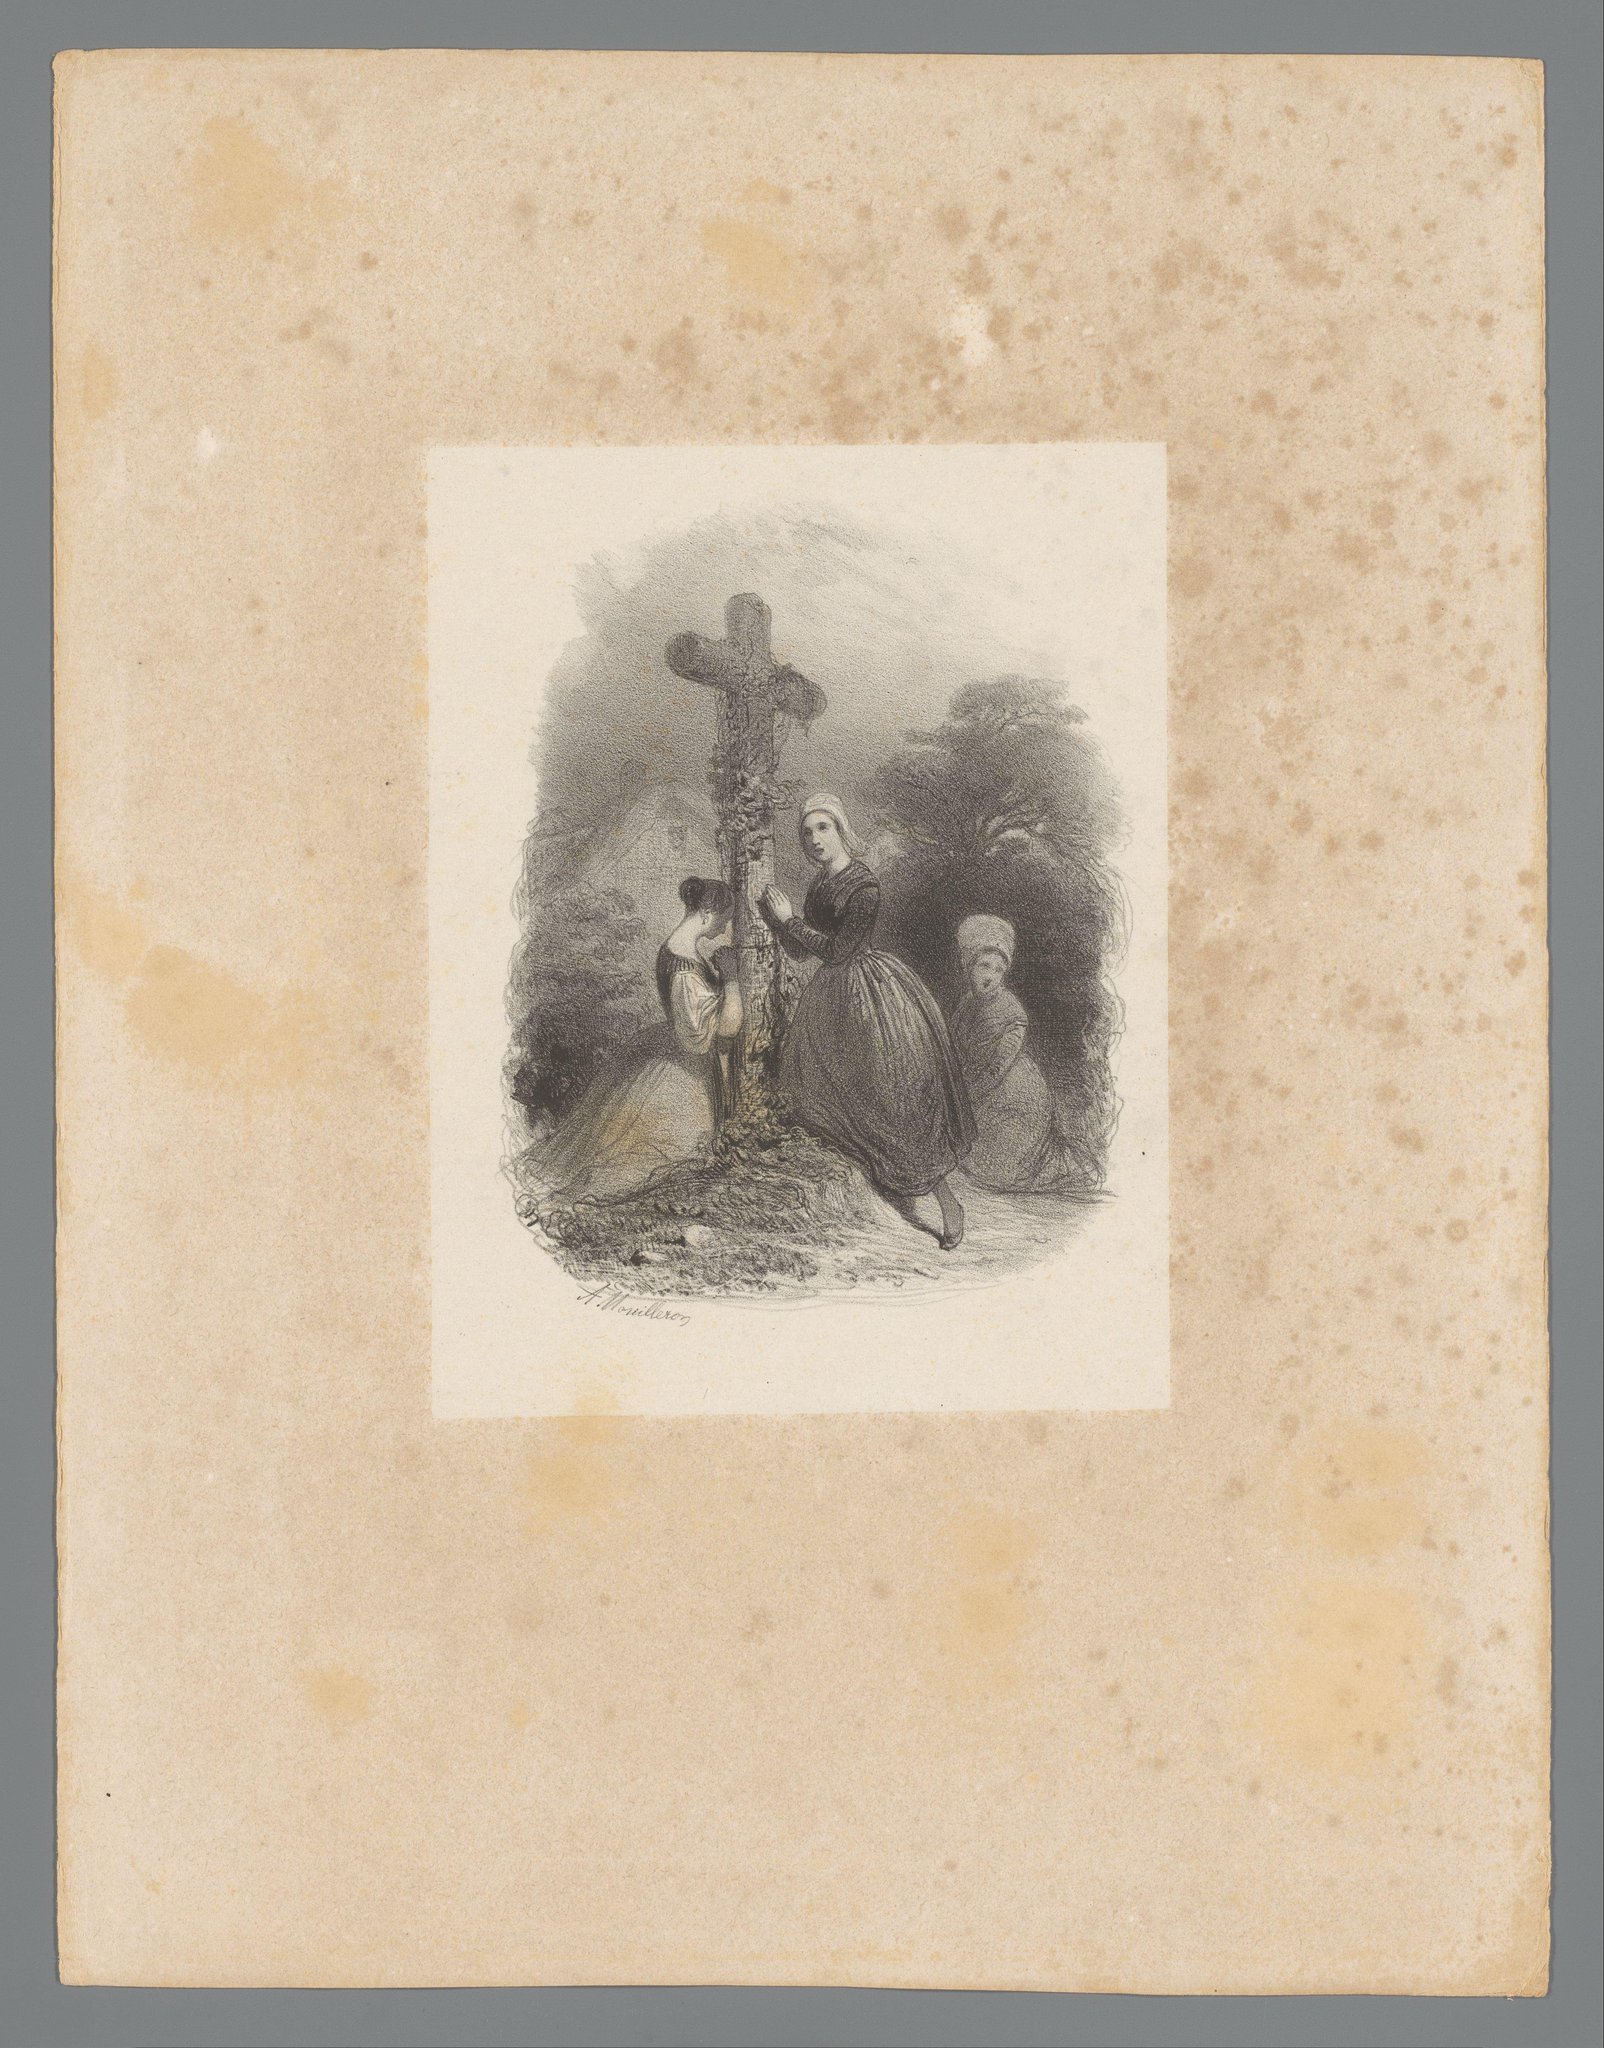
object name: print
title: Drie vrouwen bidden buiten bij een kruis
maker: adolphe mouilleron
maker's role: draughtsman, print maker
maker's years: 1820-1881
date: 1830-1881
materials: paper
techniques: lithograph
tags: (private) prayer; 'oratione', 'preghiere', 'preghiere a dio' (ripa) (+ holy ghost (as a dove)), adult woman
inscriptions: collector's mark: Lugt 964